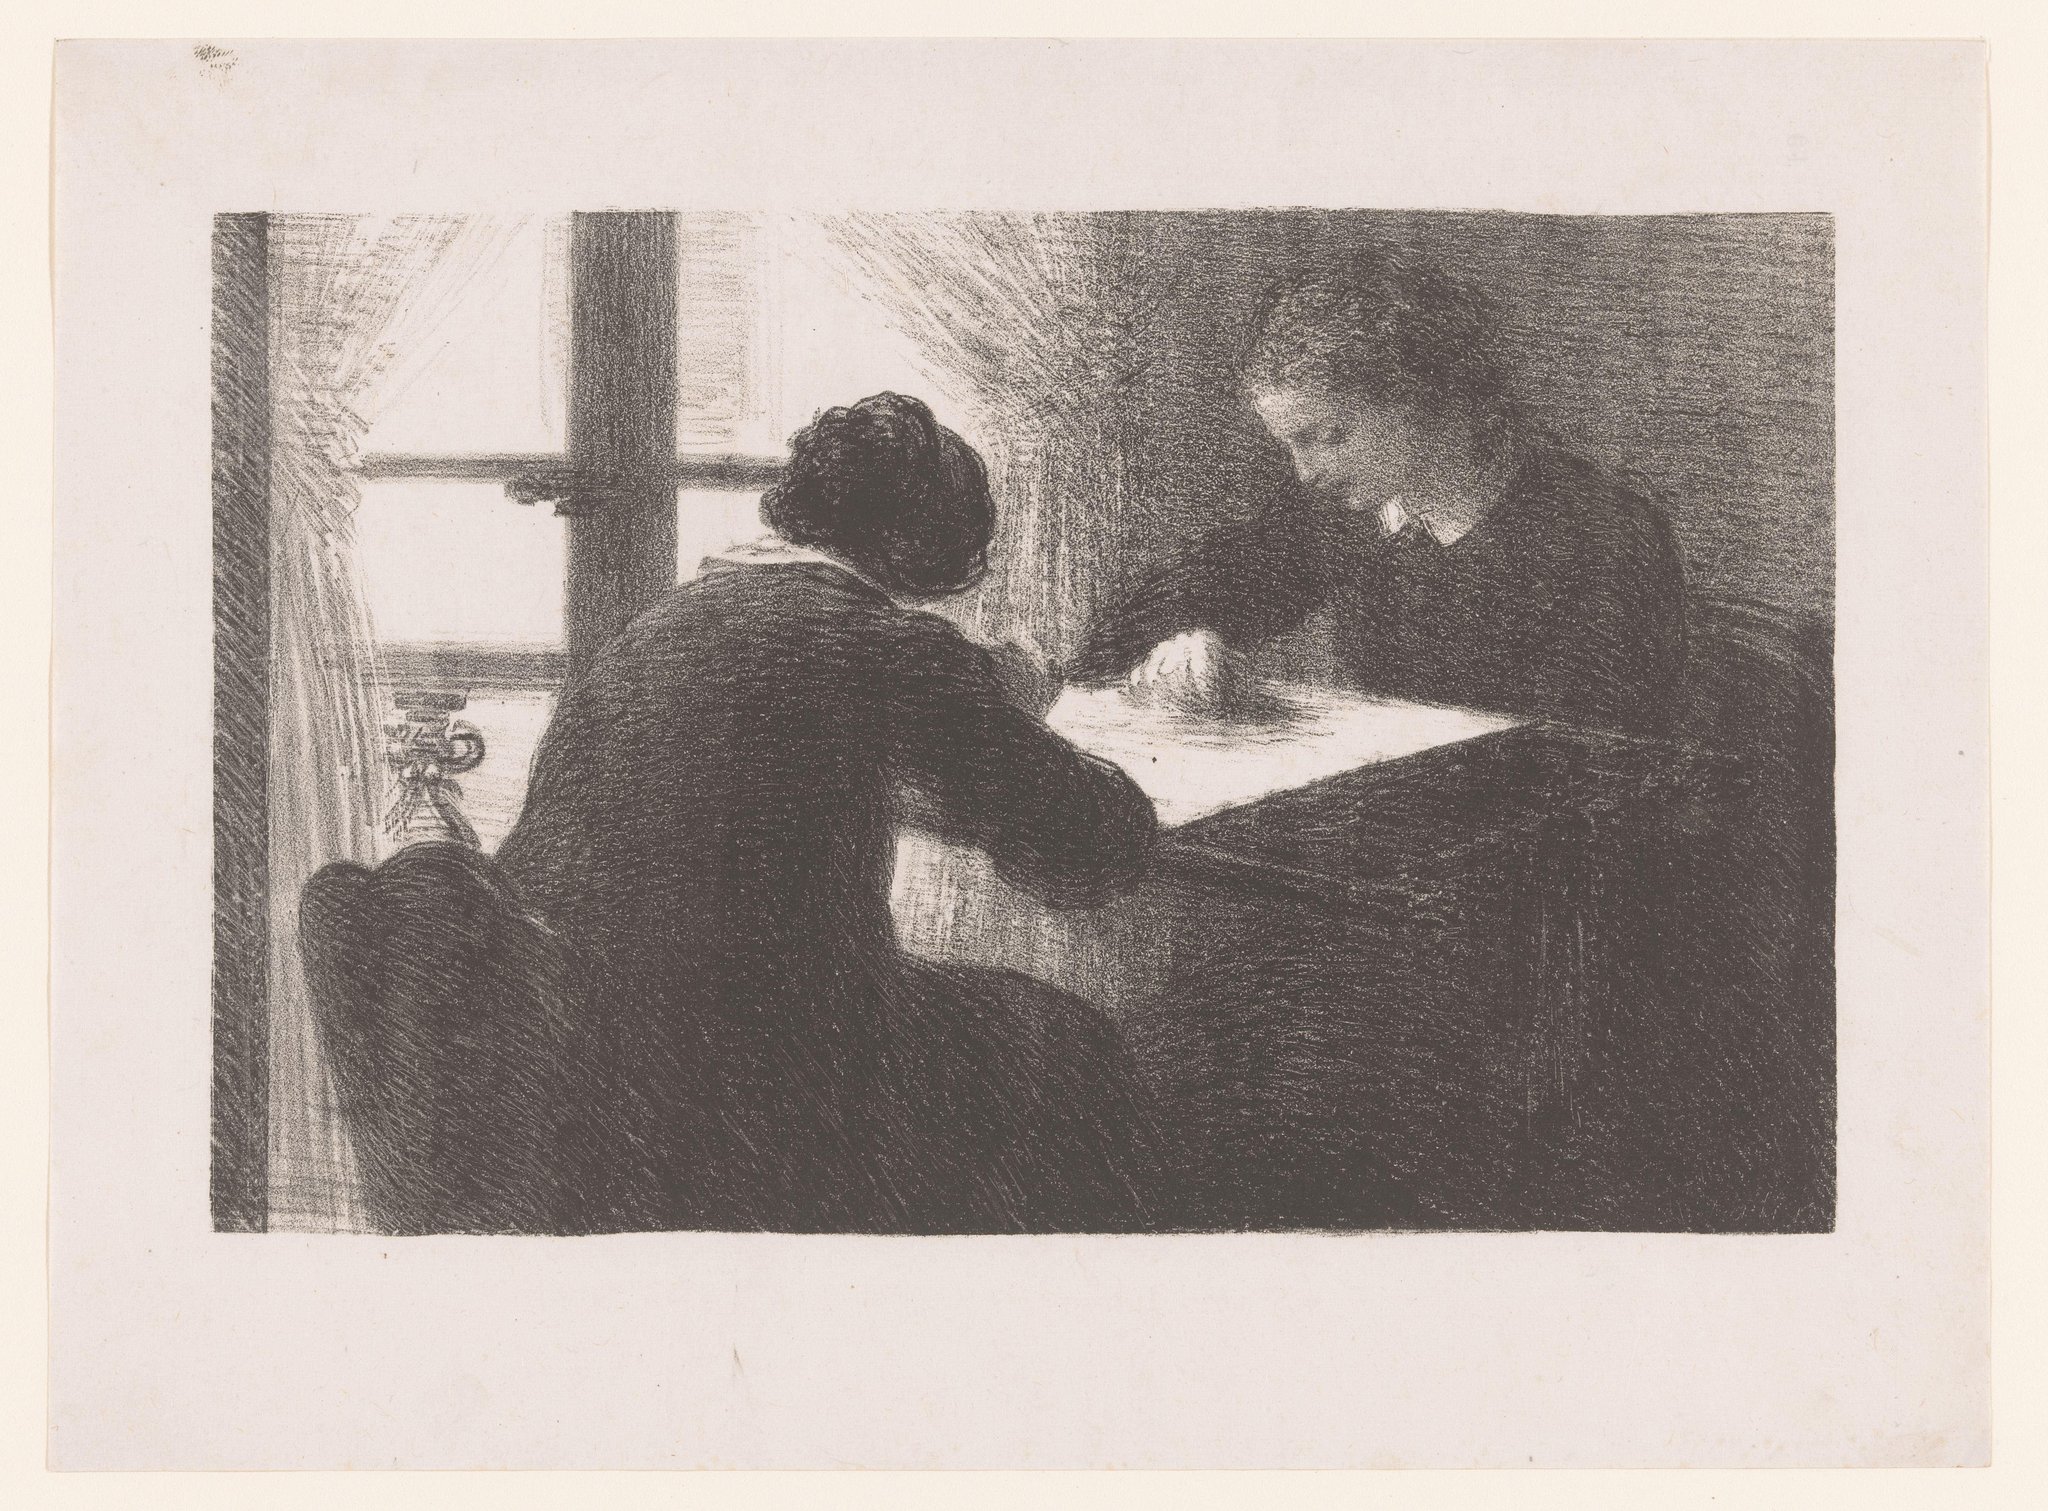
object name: print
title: Twee borduursters aan een tafel bij het raam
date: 1898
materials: paper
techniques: lithography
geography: paris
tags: adult woman, human figure at (open) window, seen from inside, embroidery (ornamentation)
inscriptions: collector's mark: Lugt 2760, collector's mark: Lugt 2228a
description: Prent gebruikt voor: Revue de l'Art ancien et moderne, januari 1899, en voor: Catalogue de l’exposition des lithographies de Fantin-Latour au Luxembourg, juni 1899.